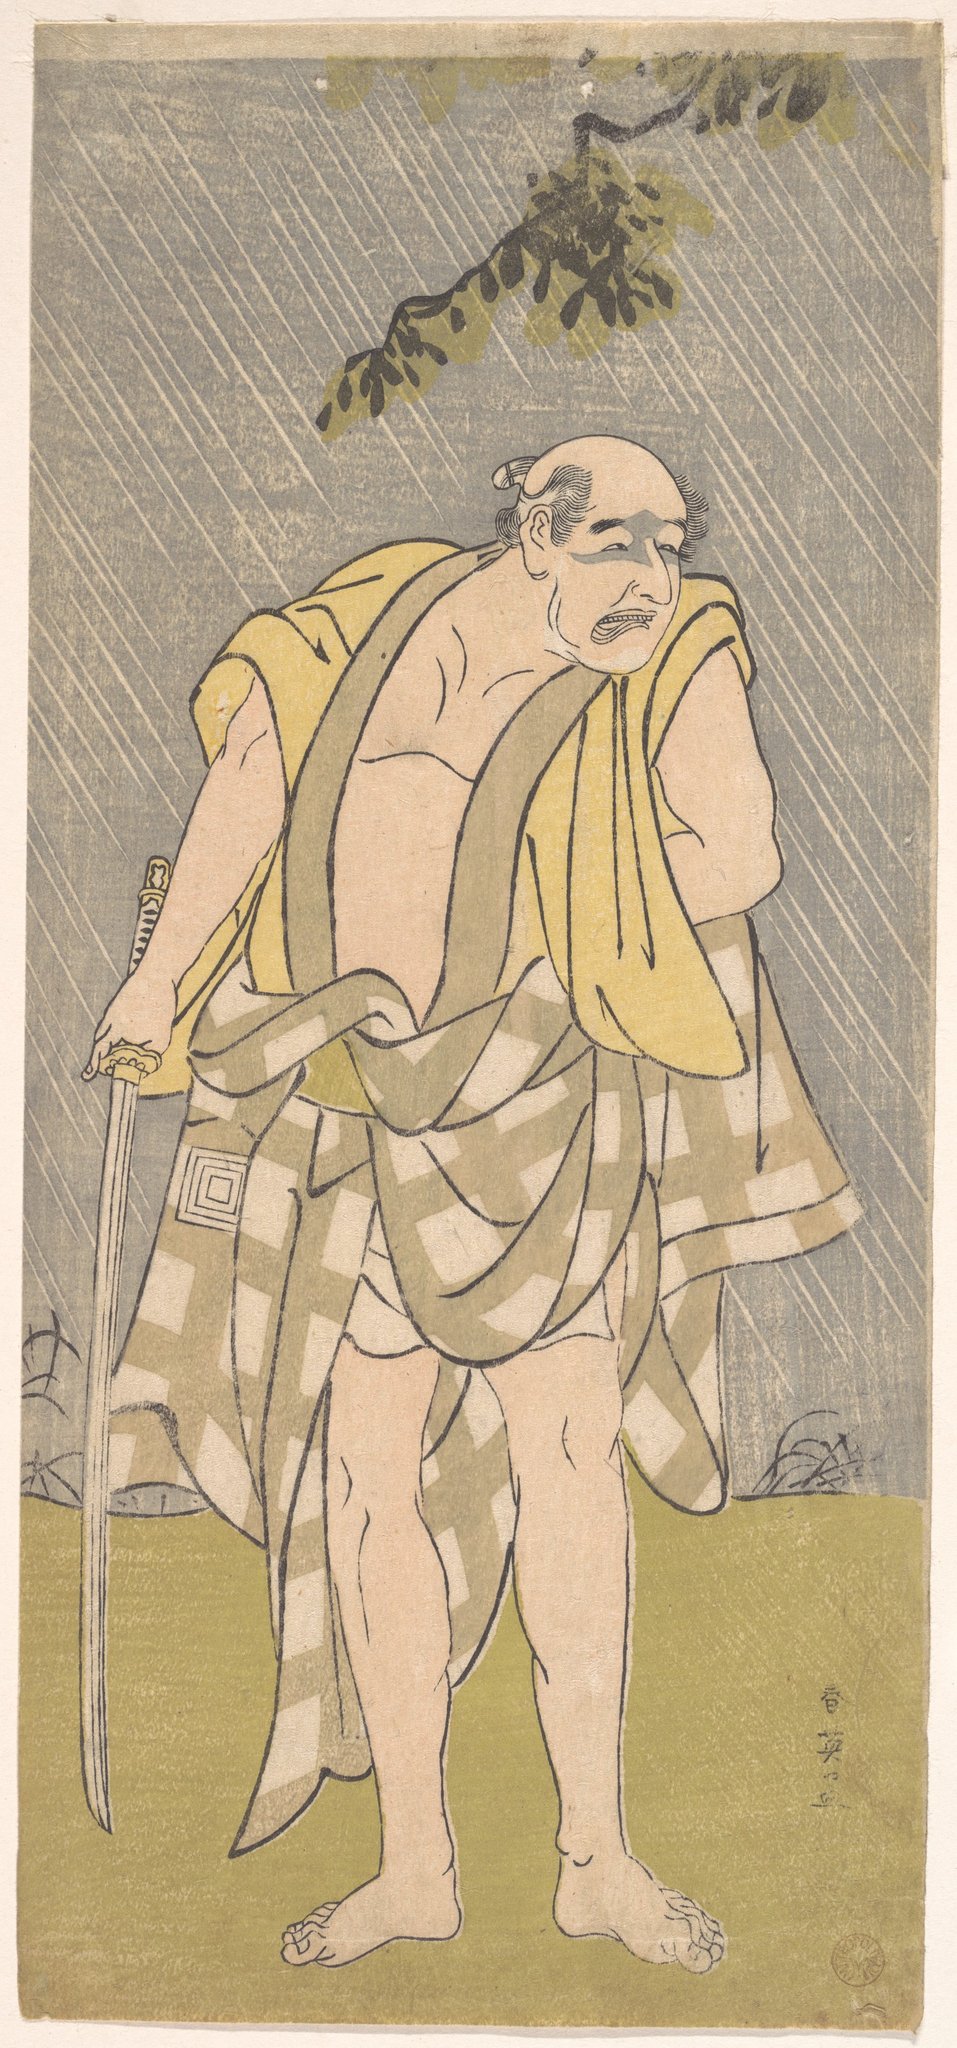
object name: print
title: The Actor Ichikawa Danzō IV in the Role of Ono Sadakurō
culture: japanese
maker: katsukawa shun'ei 勝川春英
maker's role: artist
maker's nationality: japanese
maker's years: 1762-1819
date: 1781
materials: ink, paper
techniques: woodblock print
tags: swords,rain,actors